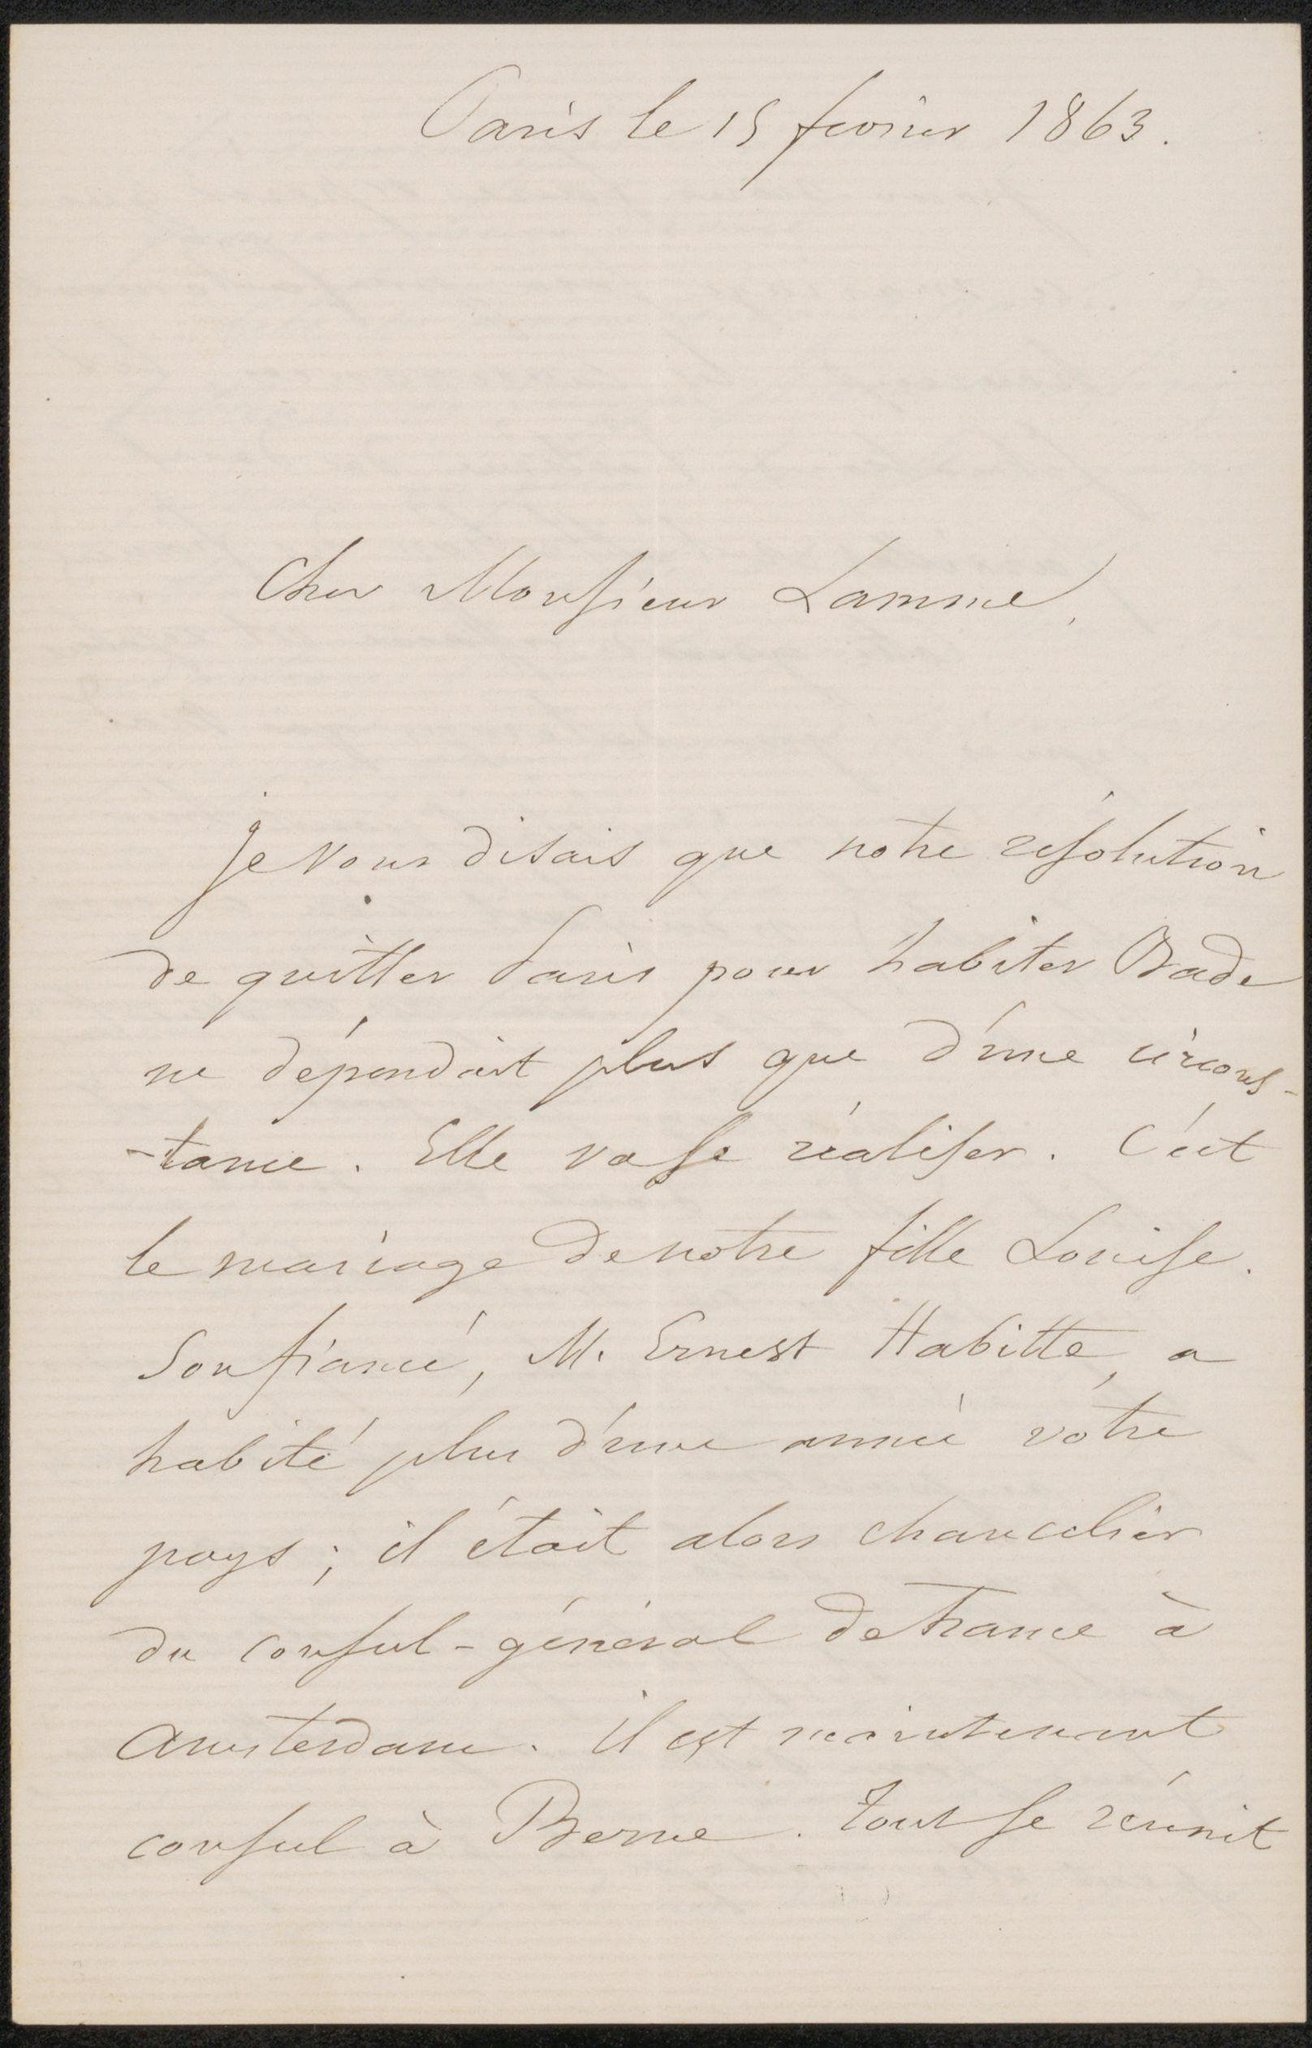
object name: letter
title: Brief aan Ary Johannes Lamme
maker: léon viardot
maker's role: print maker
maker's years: 1805-1900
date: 1863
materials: ink, paper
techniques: pen, writing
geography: paris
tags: ary johannes lamme, dordrecht, painter, print maker, draughtsman, aelbert cuyp, art trade, art shop, family life, painting (including book-illumination, miniature-painting)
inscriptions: collector's mark: Lugt 2228